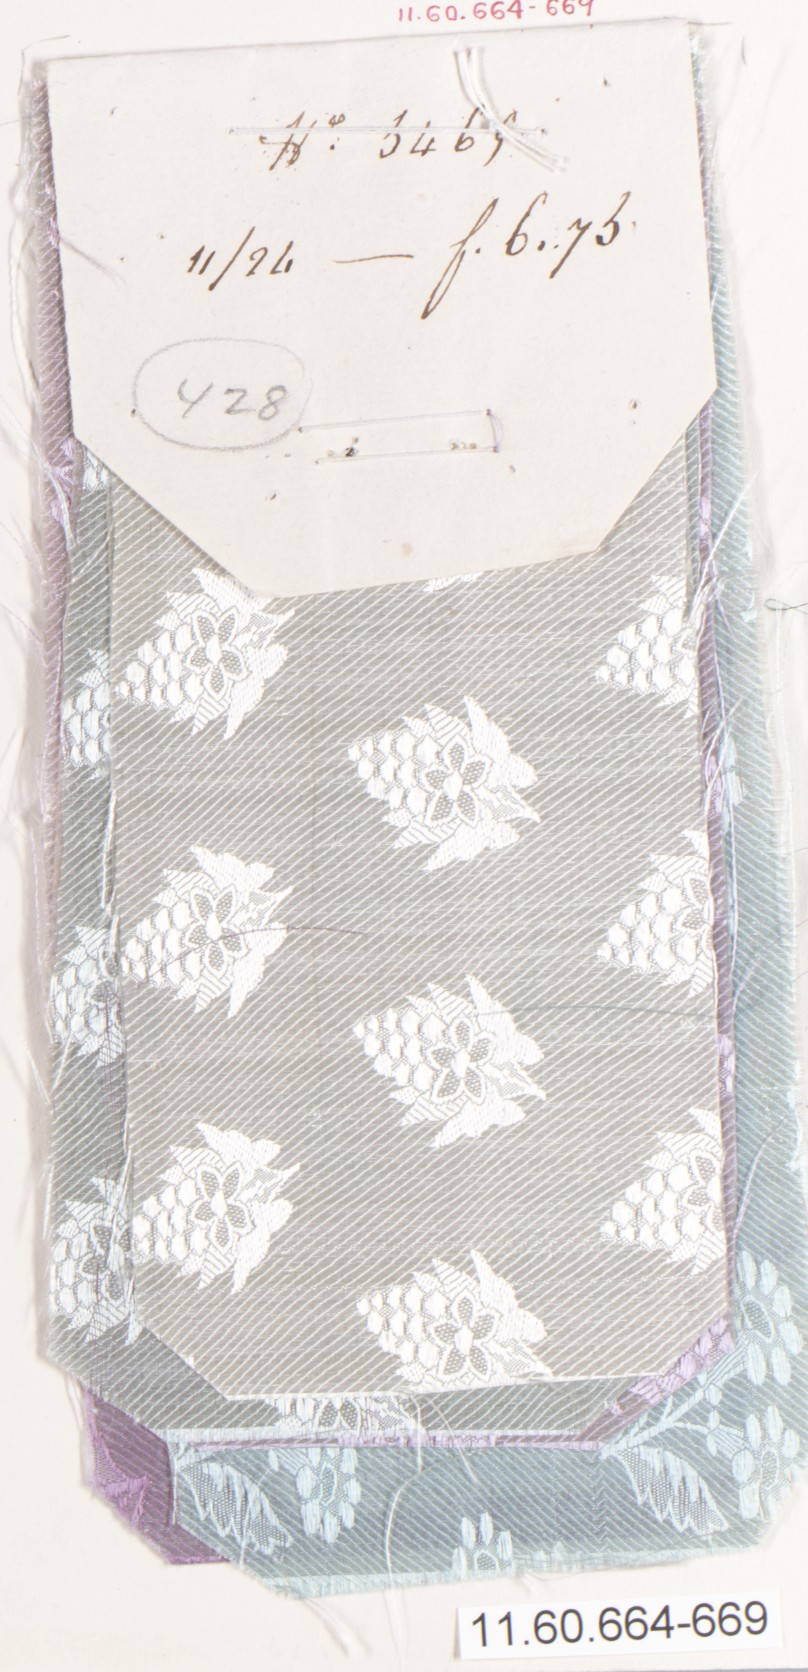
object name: sample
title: Samples (5)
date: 1801-1833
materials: silk